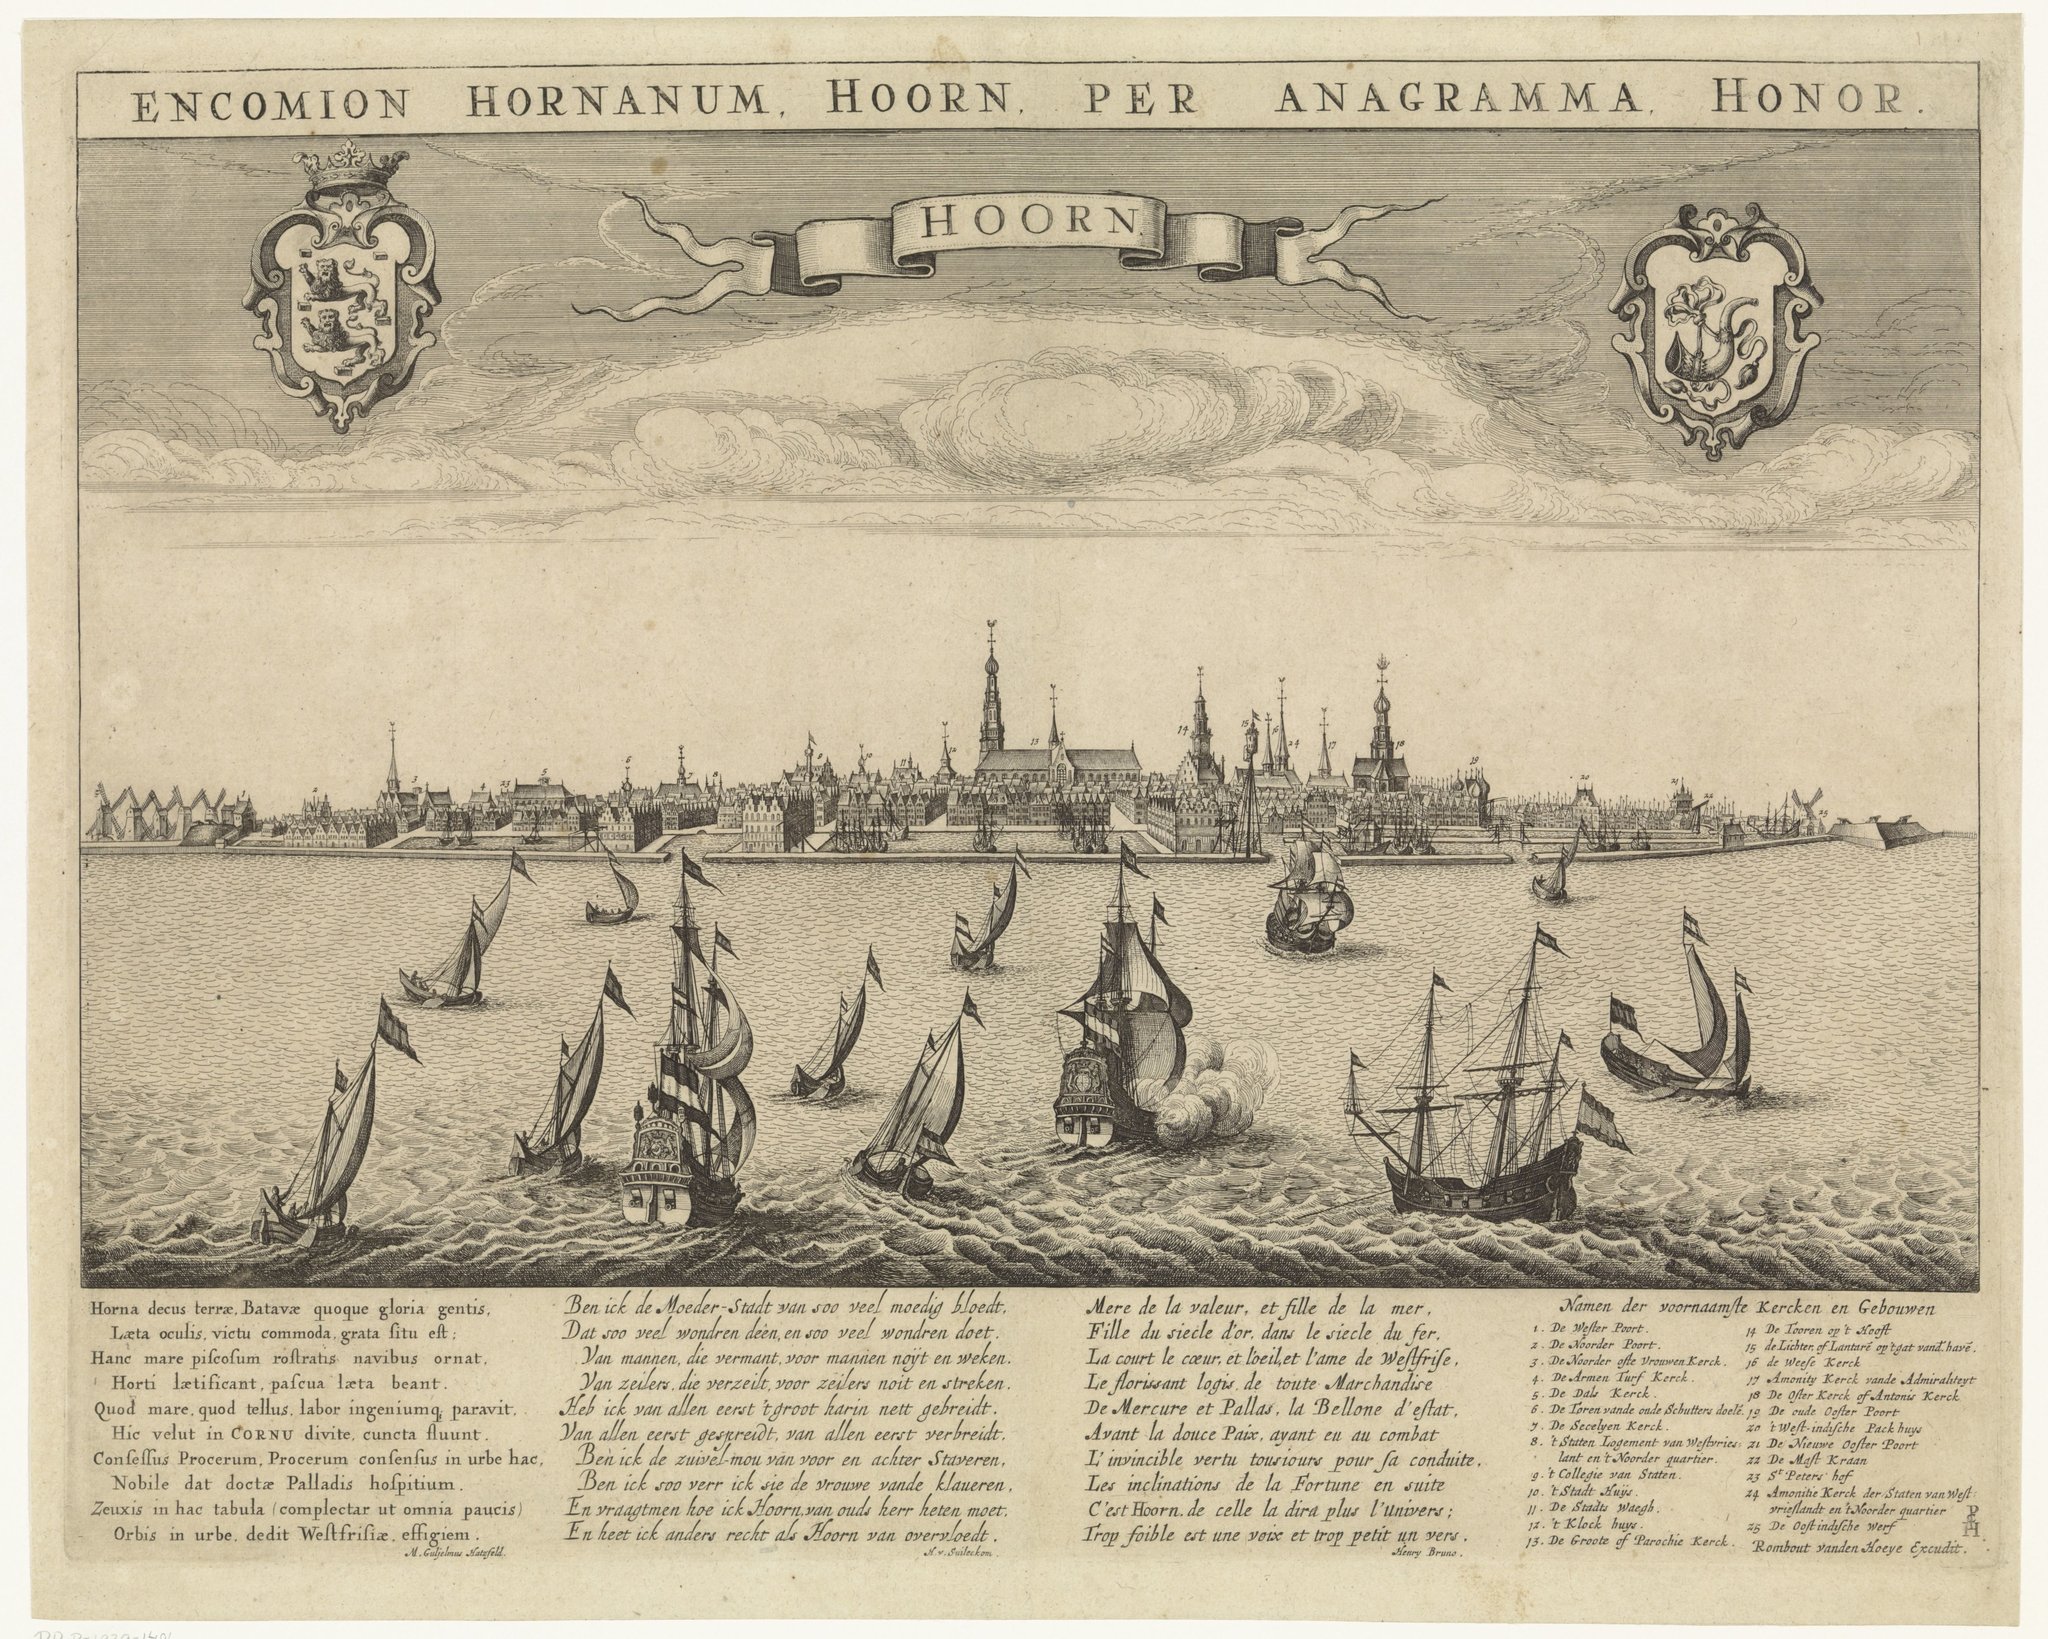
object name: print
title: Hoorn gezien vanaf de haven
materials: paper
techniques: etching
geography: amsterdam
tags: harbour, sailing-ship, sailing-boat, hoorn (north holland)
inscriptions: collector's mark: Lugt 2228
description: Zicht op Hoorn vanaf een druk bevaren zee. Onder het stadsgezicht drie lofprijzingen op Hoorn en een legenda. Boven de wolkenpartij de wapens van Hoorn en Westfriesland. Met opschrift 'Encomium Hornarum, Hoorn, per anagramma, Honor'.